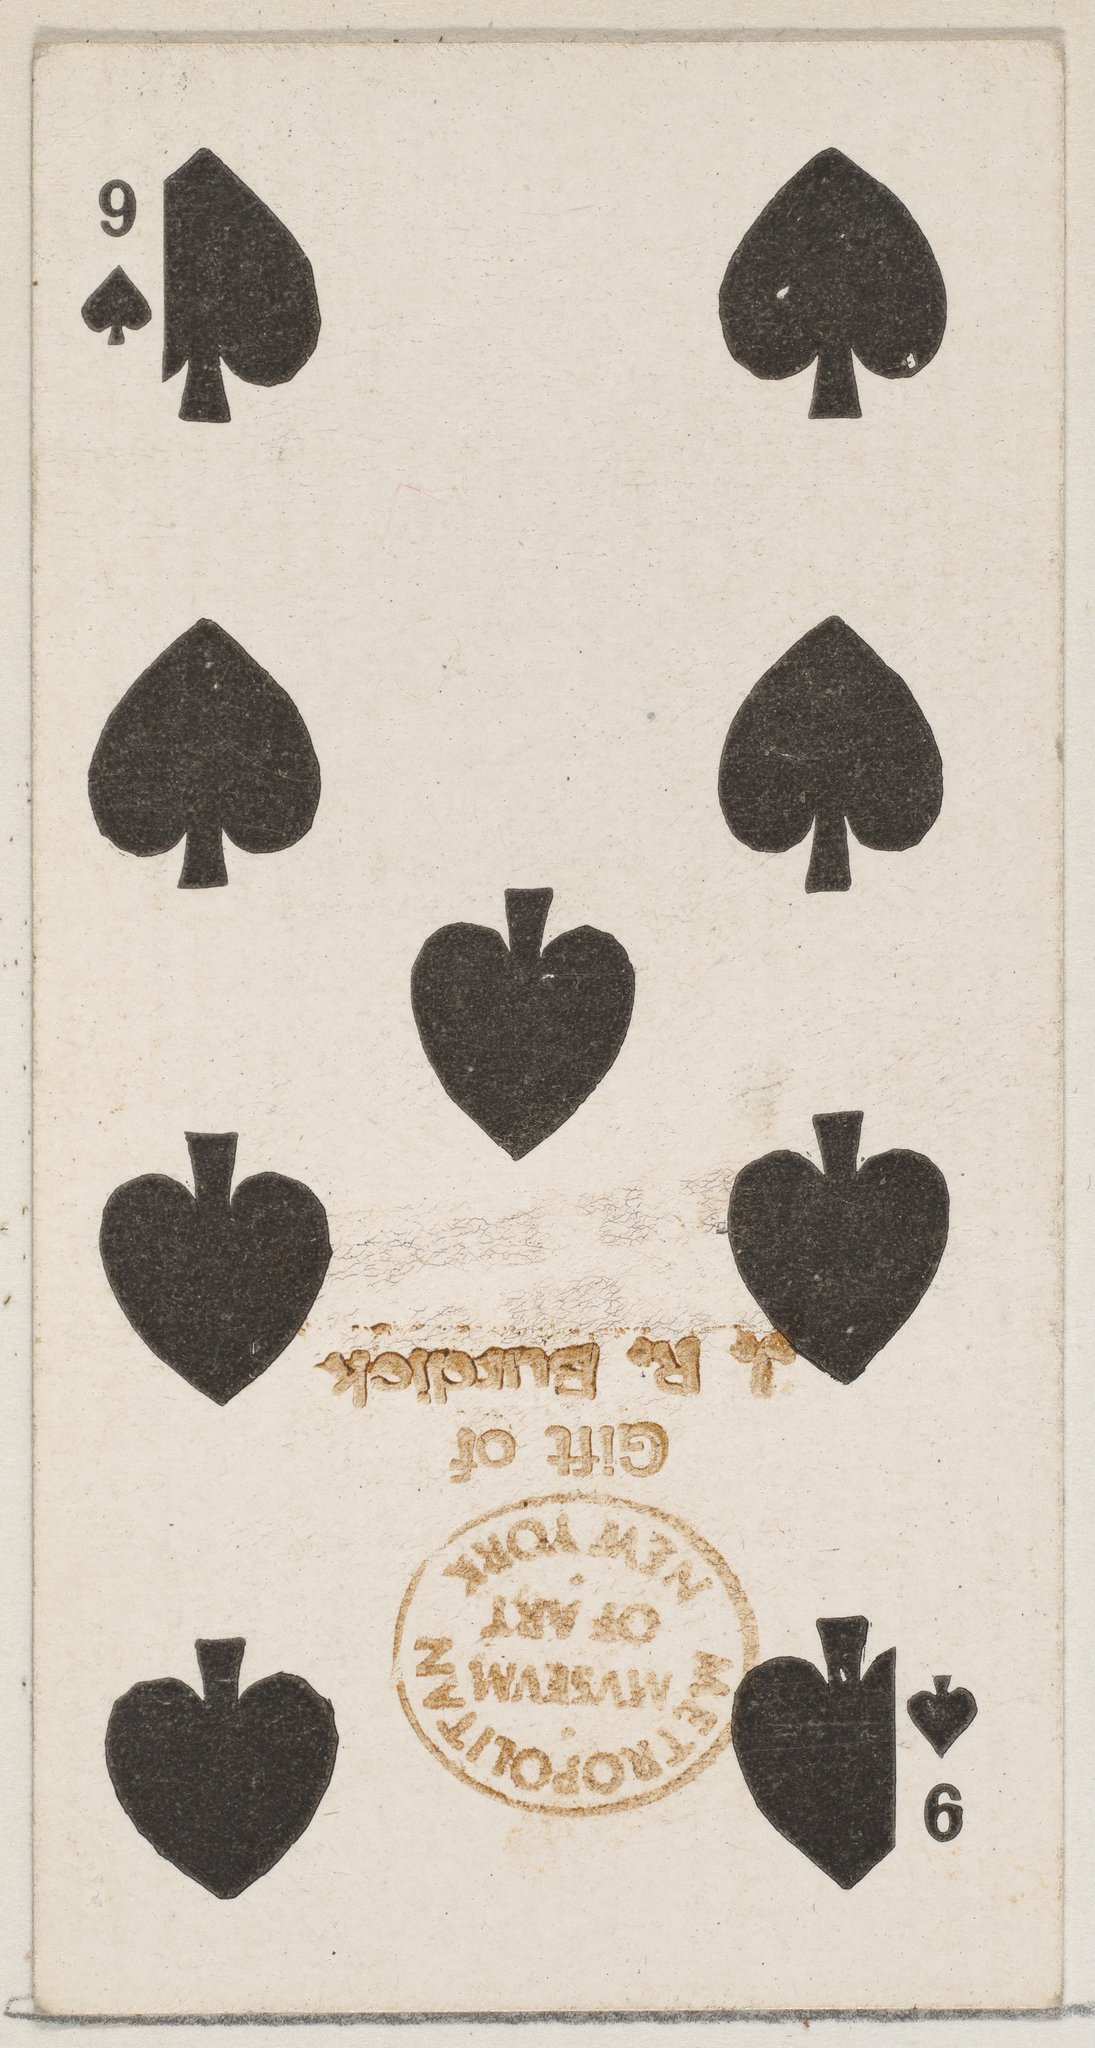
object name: print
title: Nine Spades (black), from the Playing Cards series (N84) for Duke brand cigarettes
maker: w. duke, sons & co.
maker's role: publisher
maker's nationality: american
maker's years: 1870-1920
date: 1888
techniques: color lithograph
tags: playing cards